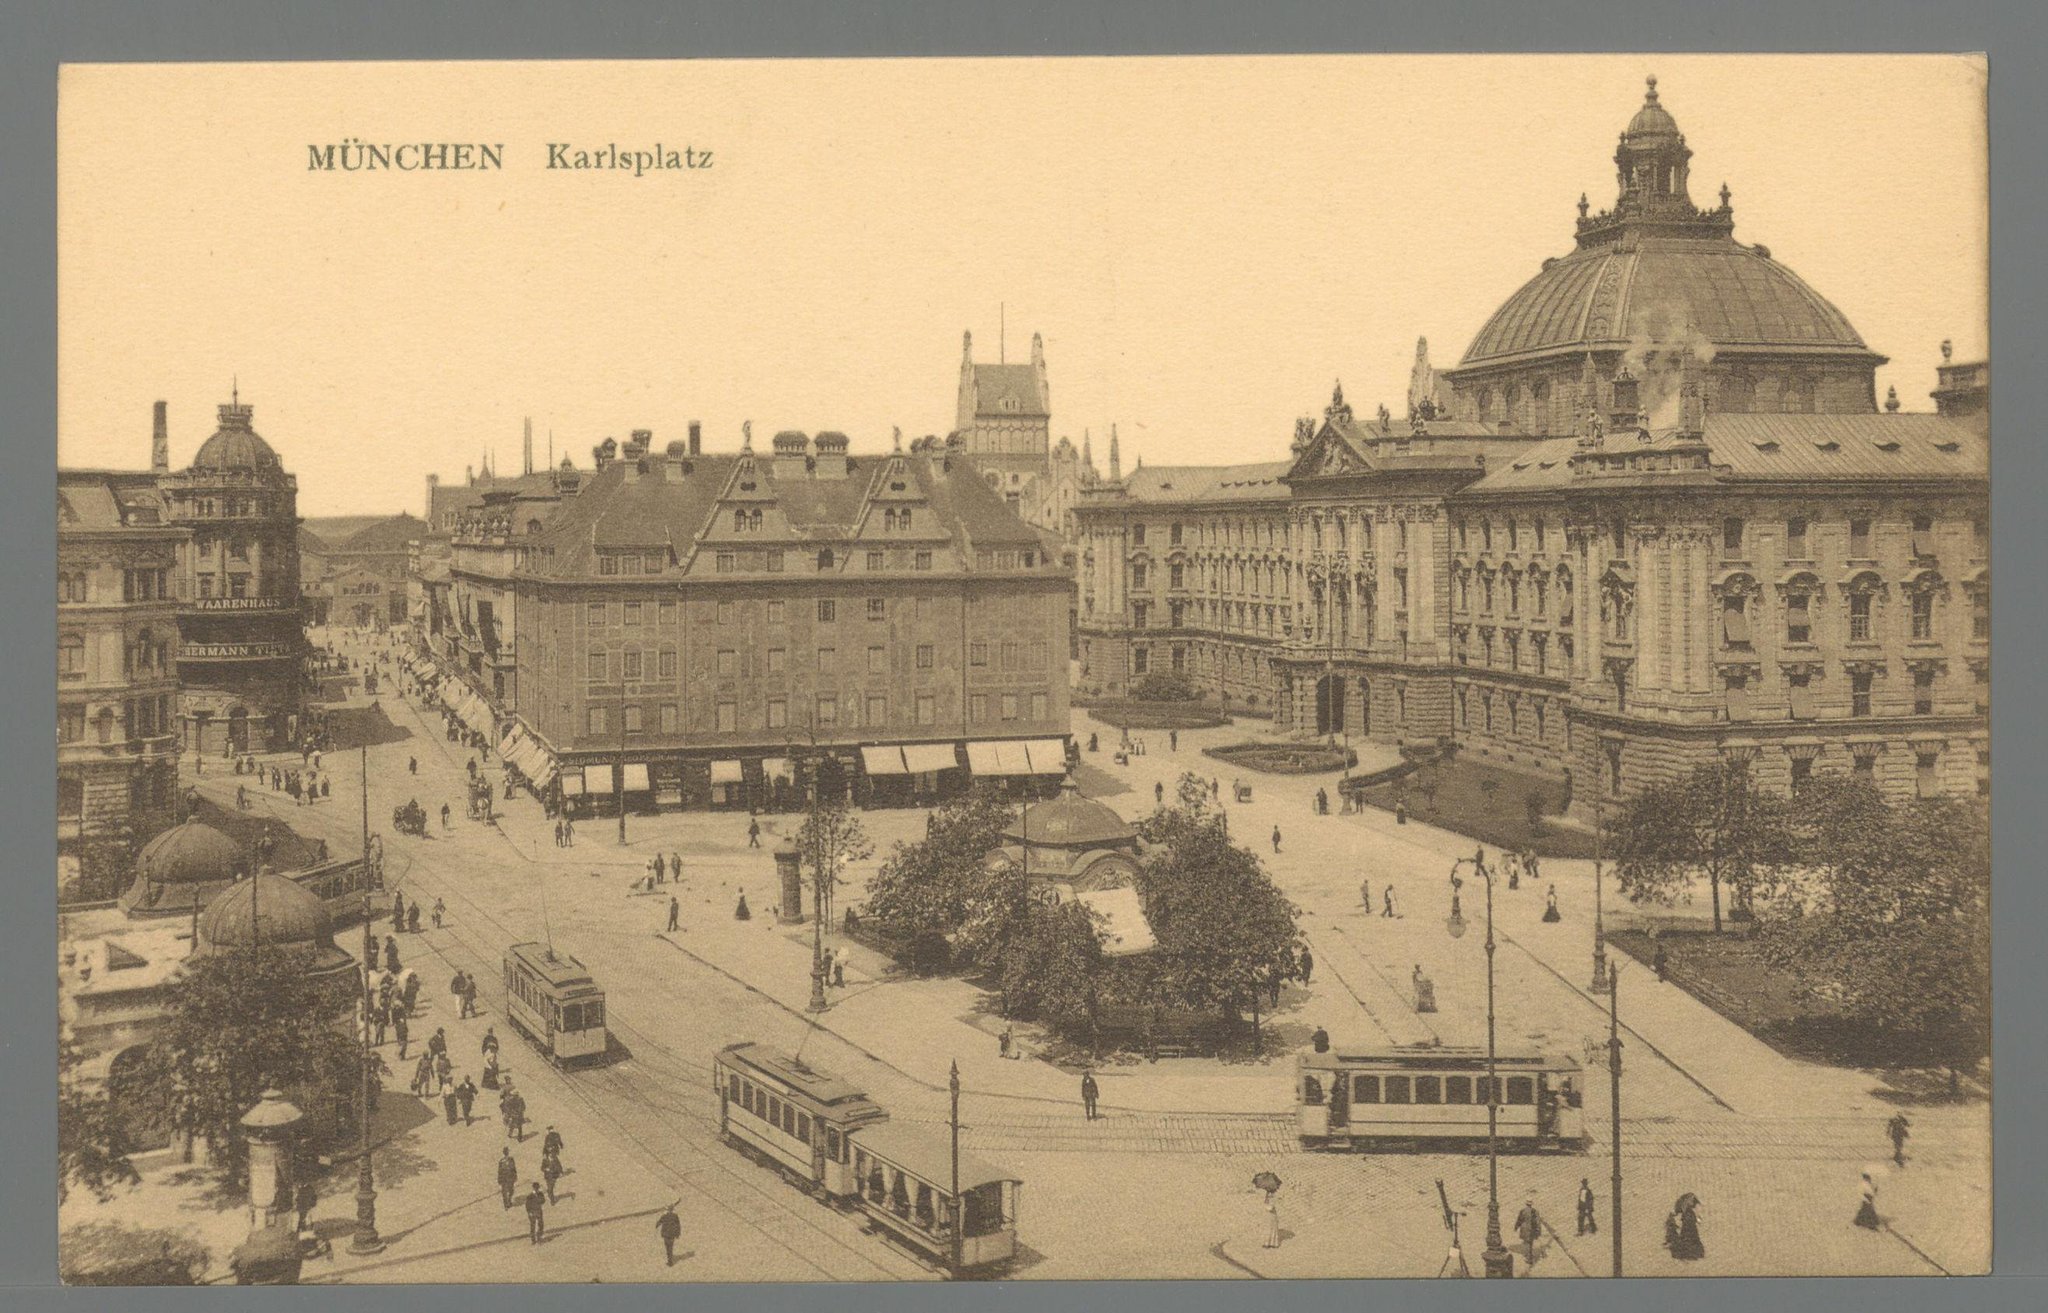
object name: ansichtkaart, prentbriefkaart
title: München. Karlsplatz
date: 1905-1930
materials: cardboard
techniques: photograph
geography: munich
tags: square, place, circus, etc.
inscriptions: inscription: ‘W.H.D.’